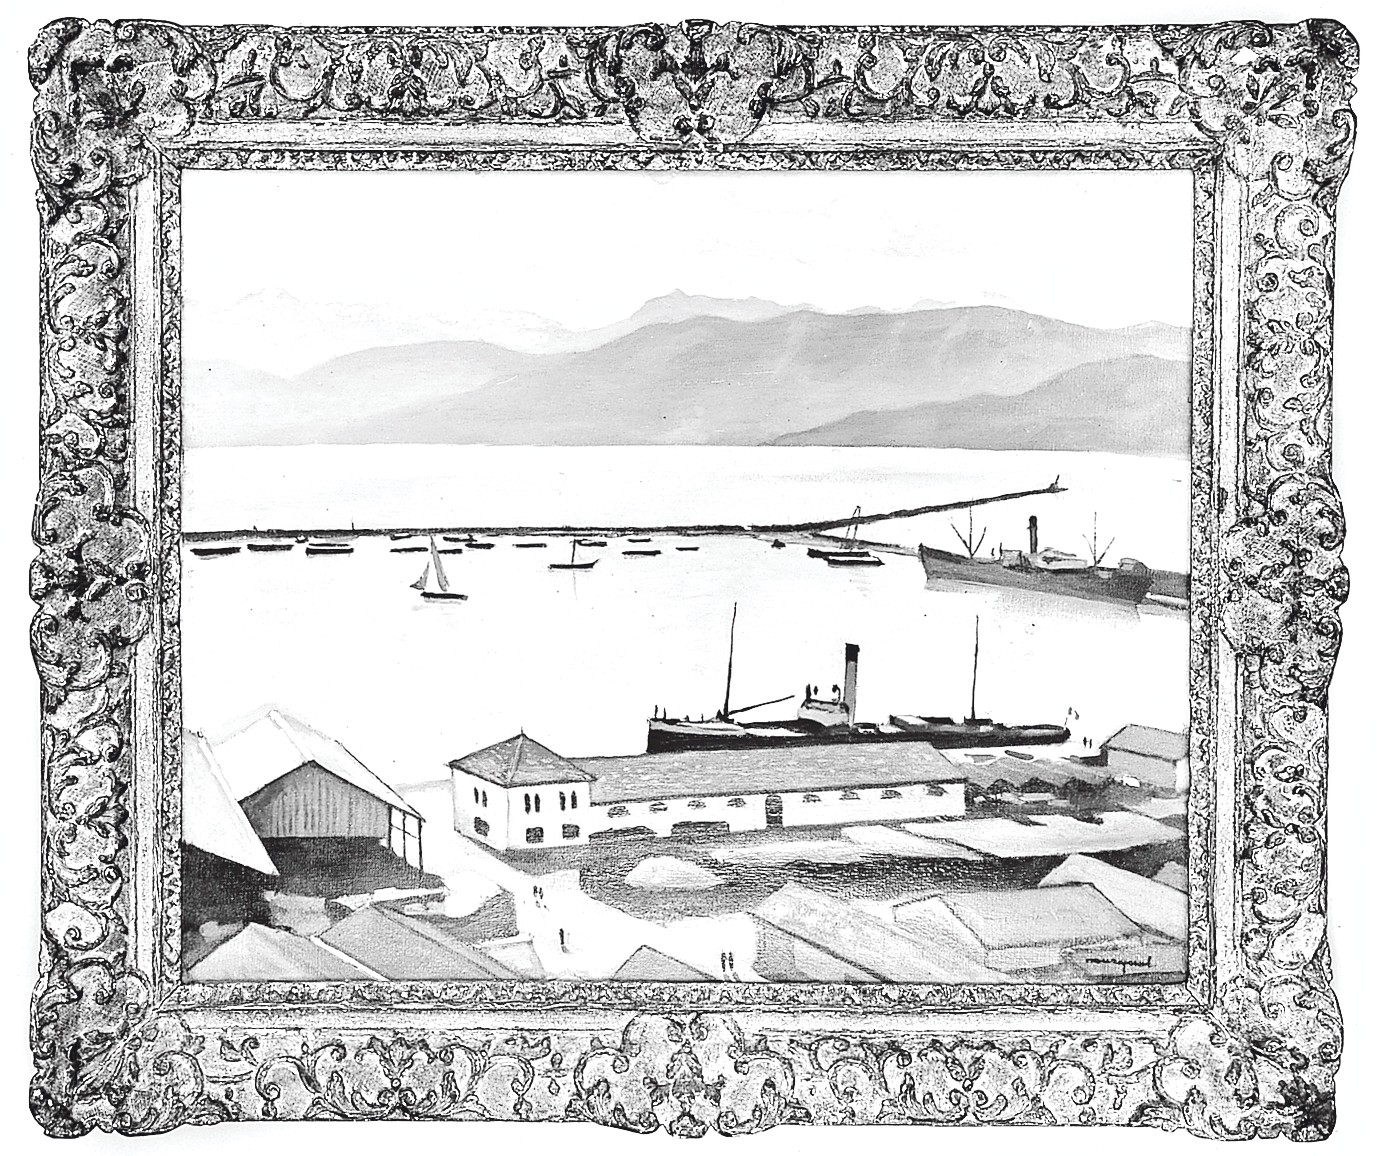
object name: frame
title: Ovolo frame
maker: france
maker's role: artist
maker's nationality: french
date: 1710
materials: wood